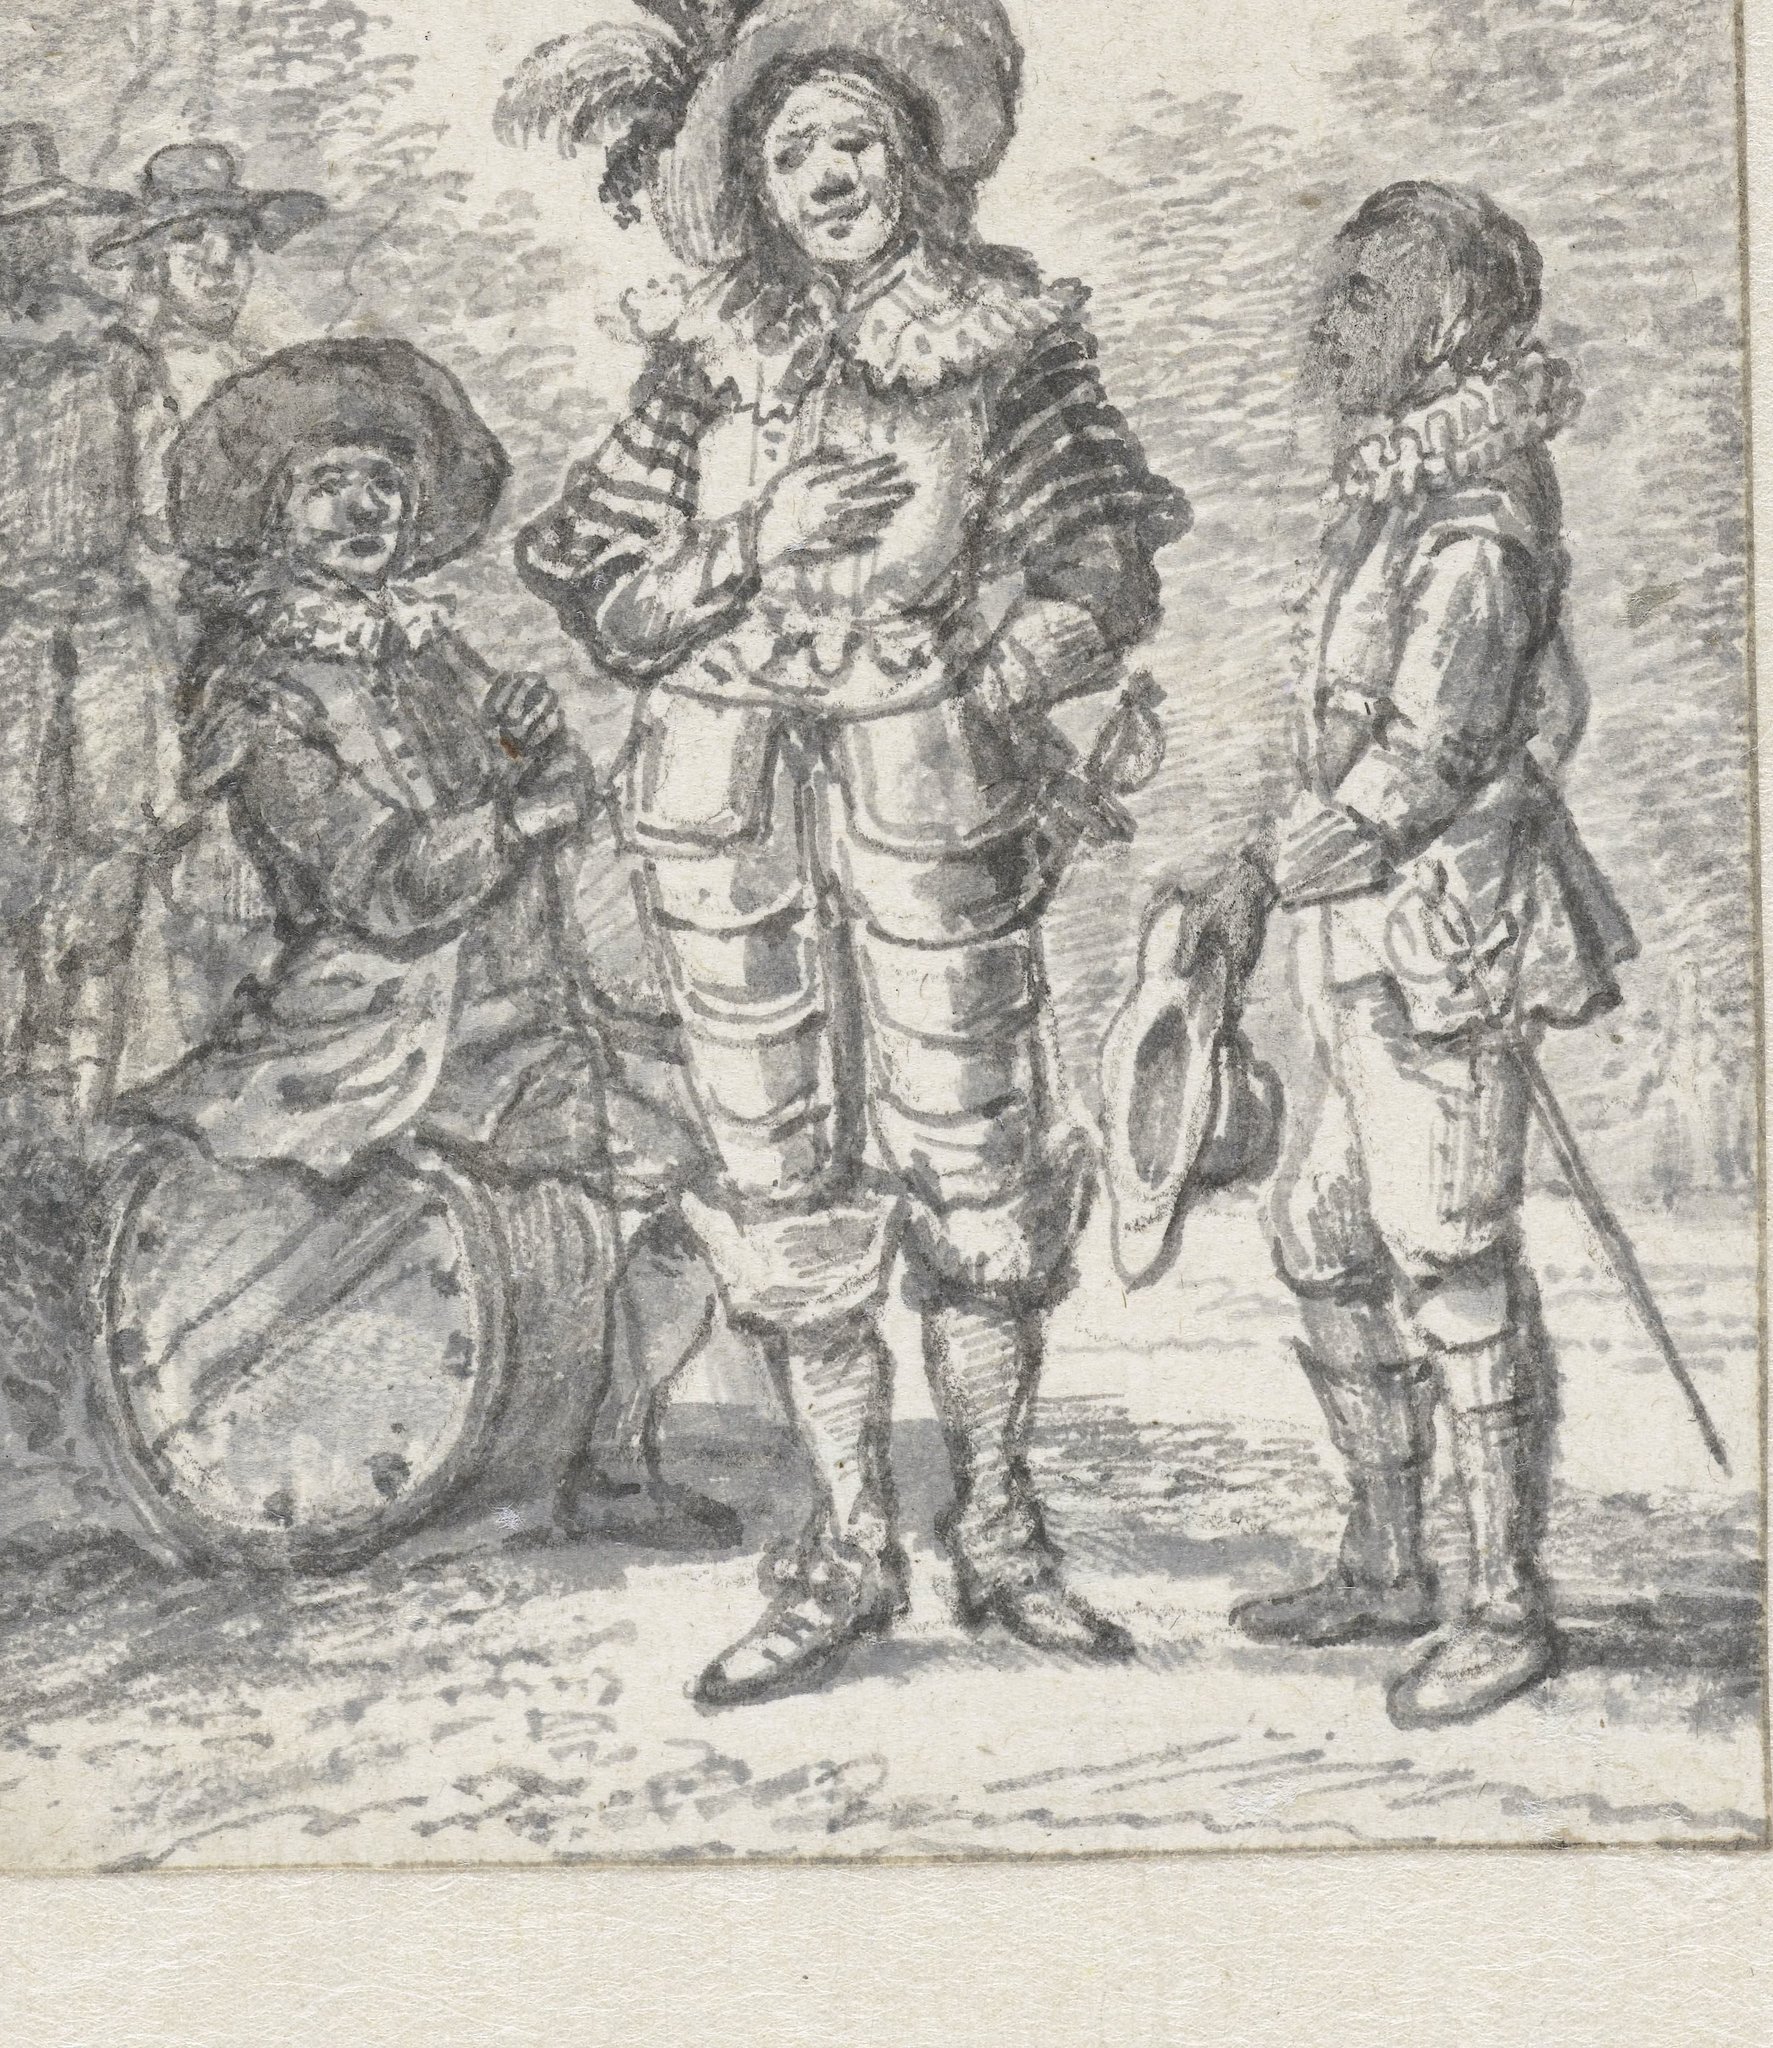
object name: design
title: Ontwerp voor illustratie toneelgroep: twee staande figuren en een zittende figuur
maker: paulus constantijn la fargue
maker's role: draughtsman, painter, print maker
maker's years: 1729-1782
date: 1739-1782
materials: ink, paper, pencil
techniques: brush, pen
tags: group of actors, troupe; actors on the stage